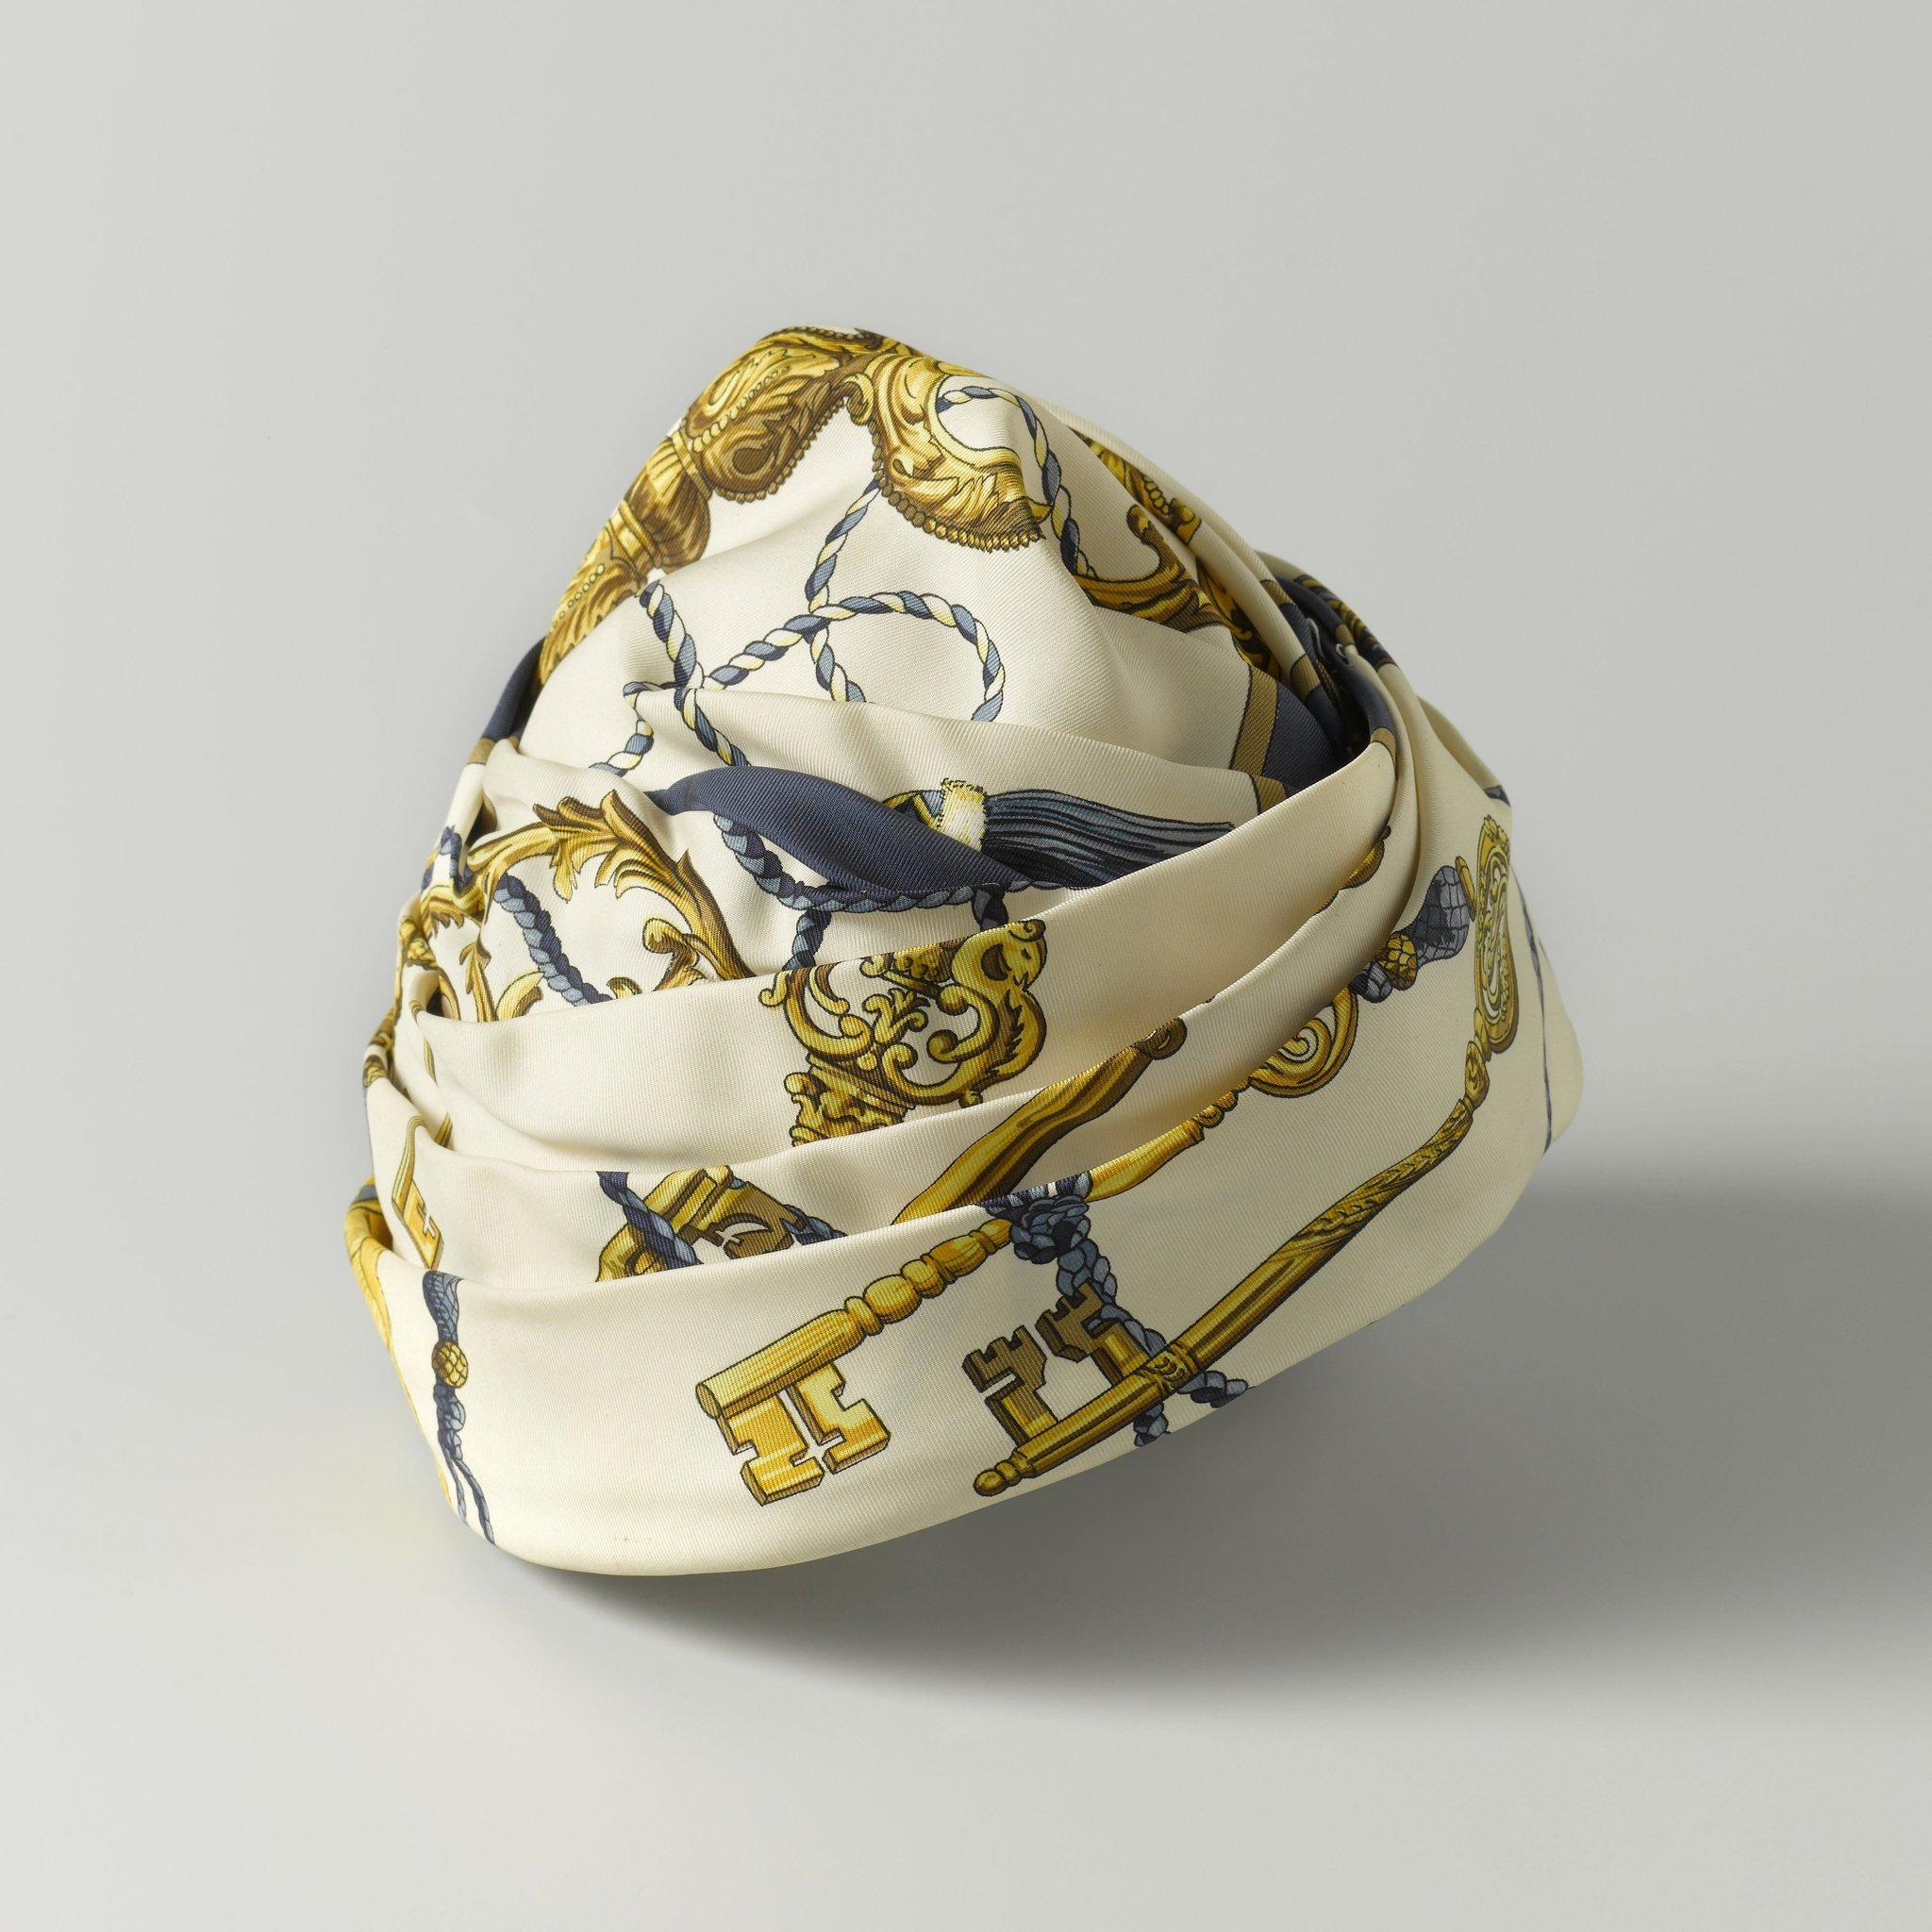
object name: womenswear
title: Tulband van foulardzijde met een blauw en geel getinte opdruk van sleutels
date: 1970-1980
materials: silk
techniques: printing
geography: paris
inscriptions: mark: ‘HERMÈS-PARIS’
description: Tulband van foulardzijde met een blauw en geel getinte opdruk van sleutels. Over een dubbele laag tule raide is de foulardzijde gedrapeerd. Hoedband van blauw grosgrain. Middenachter aan de onderzijde enkele centimeters elastiek.